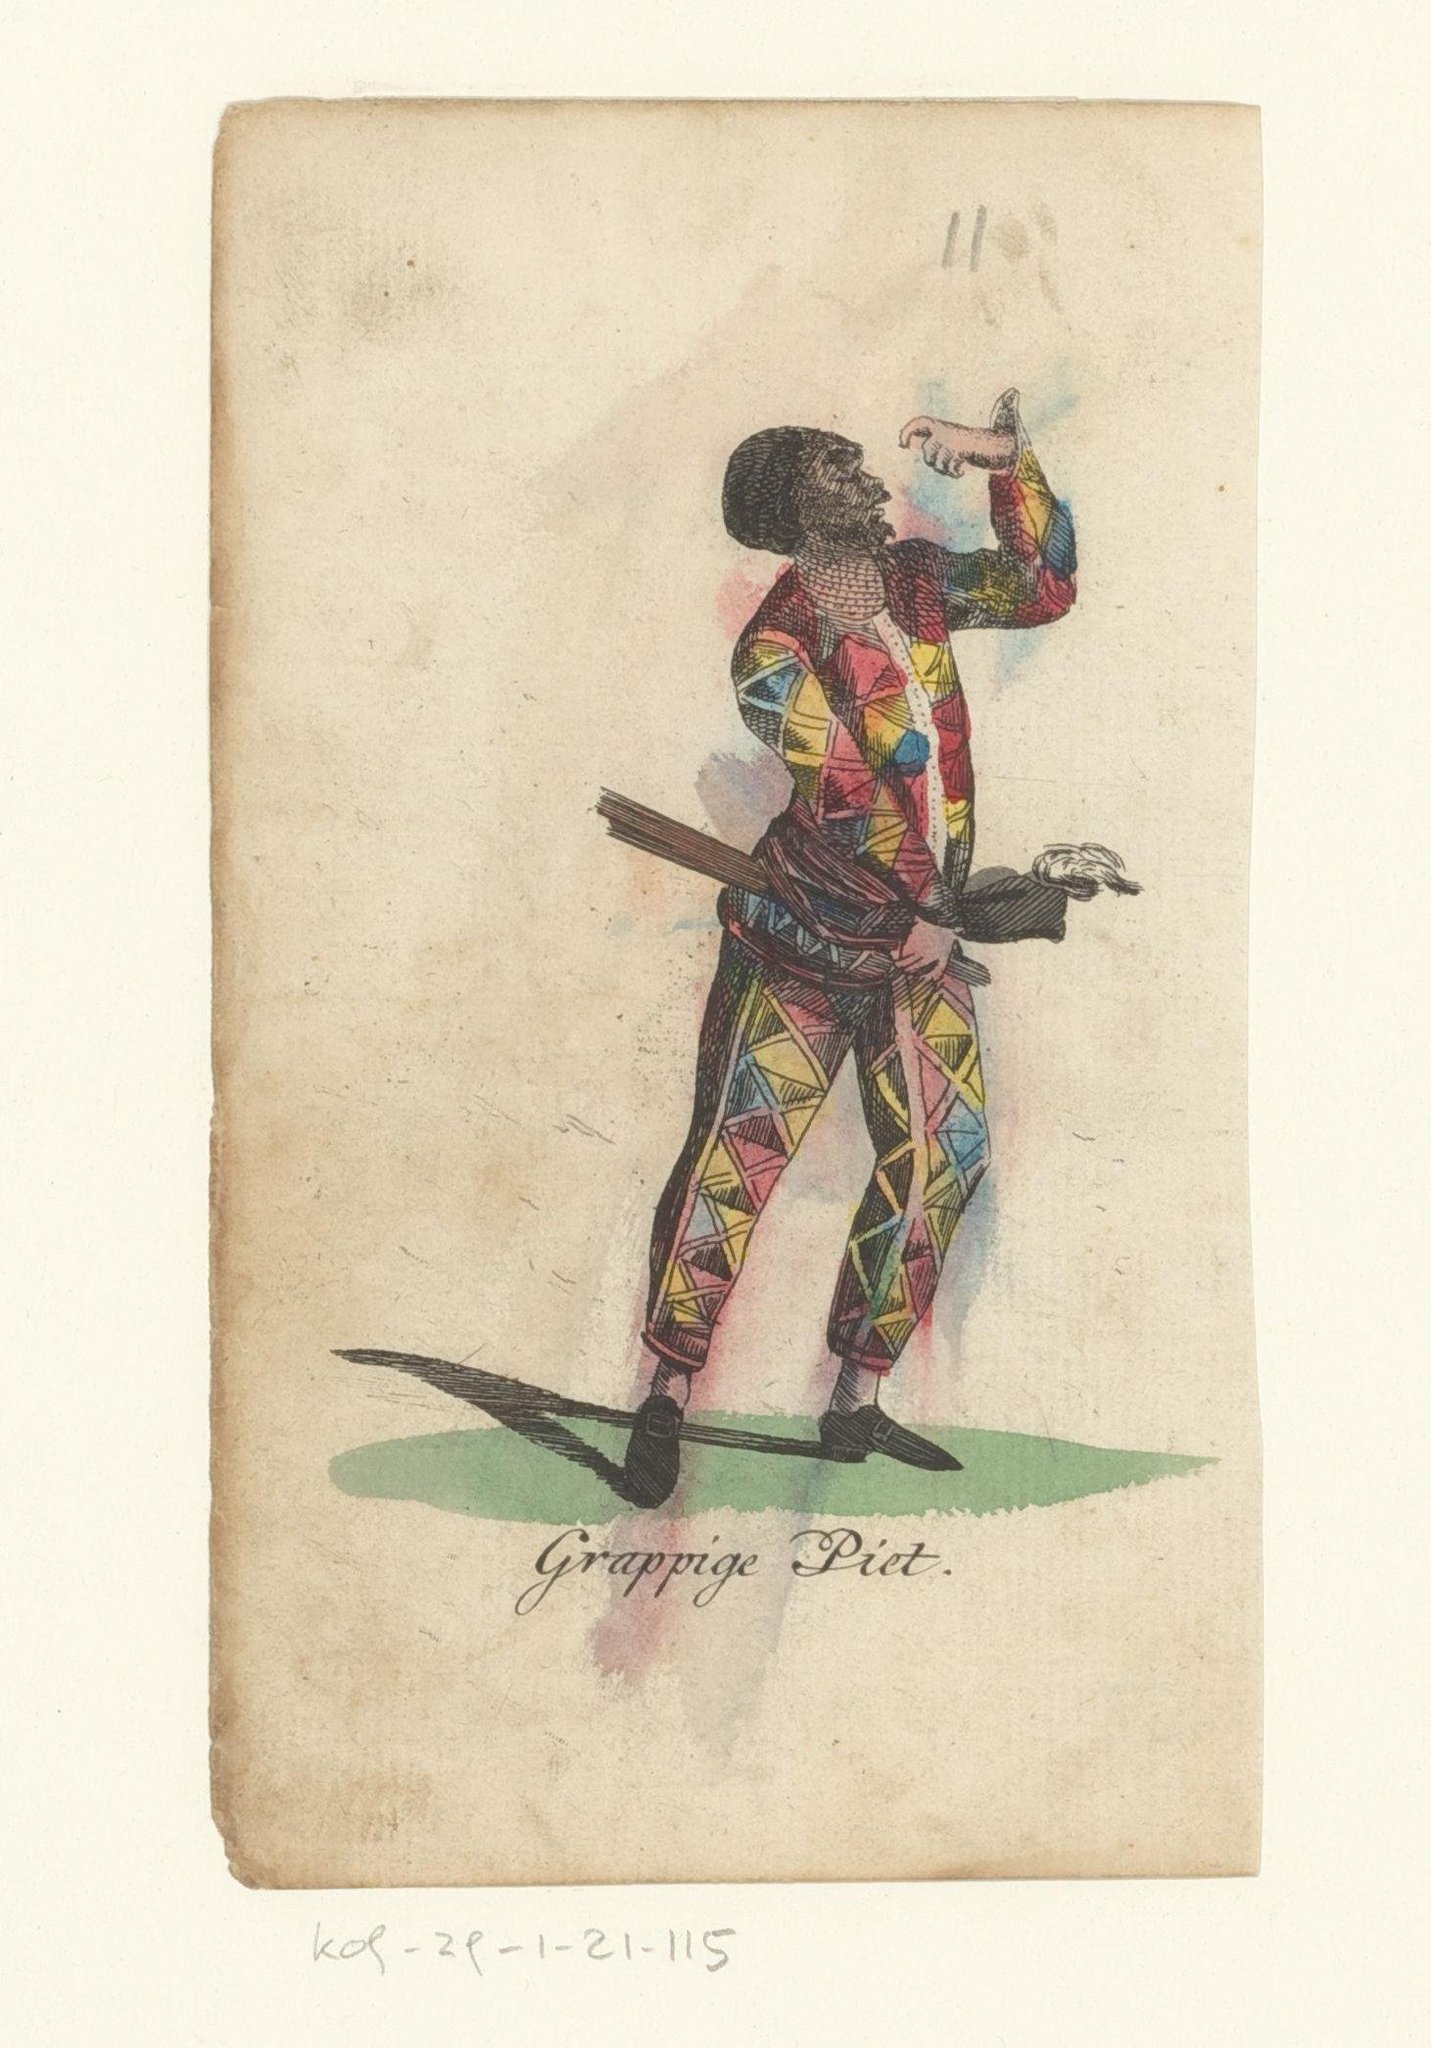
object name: print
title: Grappige Piet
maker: Anonymous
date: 1821-1829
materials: paper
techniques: engraving, etching, hand coloring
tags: types in 'commedia dell'arte': harlequin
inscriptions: collector's mark: Lugt 1641, collector's mark: Lugt 1641a, stamp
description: Het karakter Grappige Piet is een type uit het straat- en kermisleven. De verbeelde man is wit maar heeft zijn gezicht zwart gemaakt. De man draagt verder een geruit pak. Onderwerpsrubrieken binnen de Atlas Zeden en Gewoonten: Zeden en Gewoonten in Engeren Zin, De Kleeding, Kleederdrachten (tijdvakken), De 18de eeuw (de revolutietijd). Mannen en vrouwen.